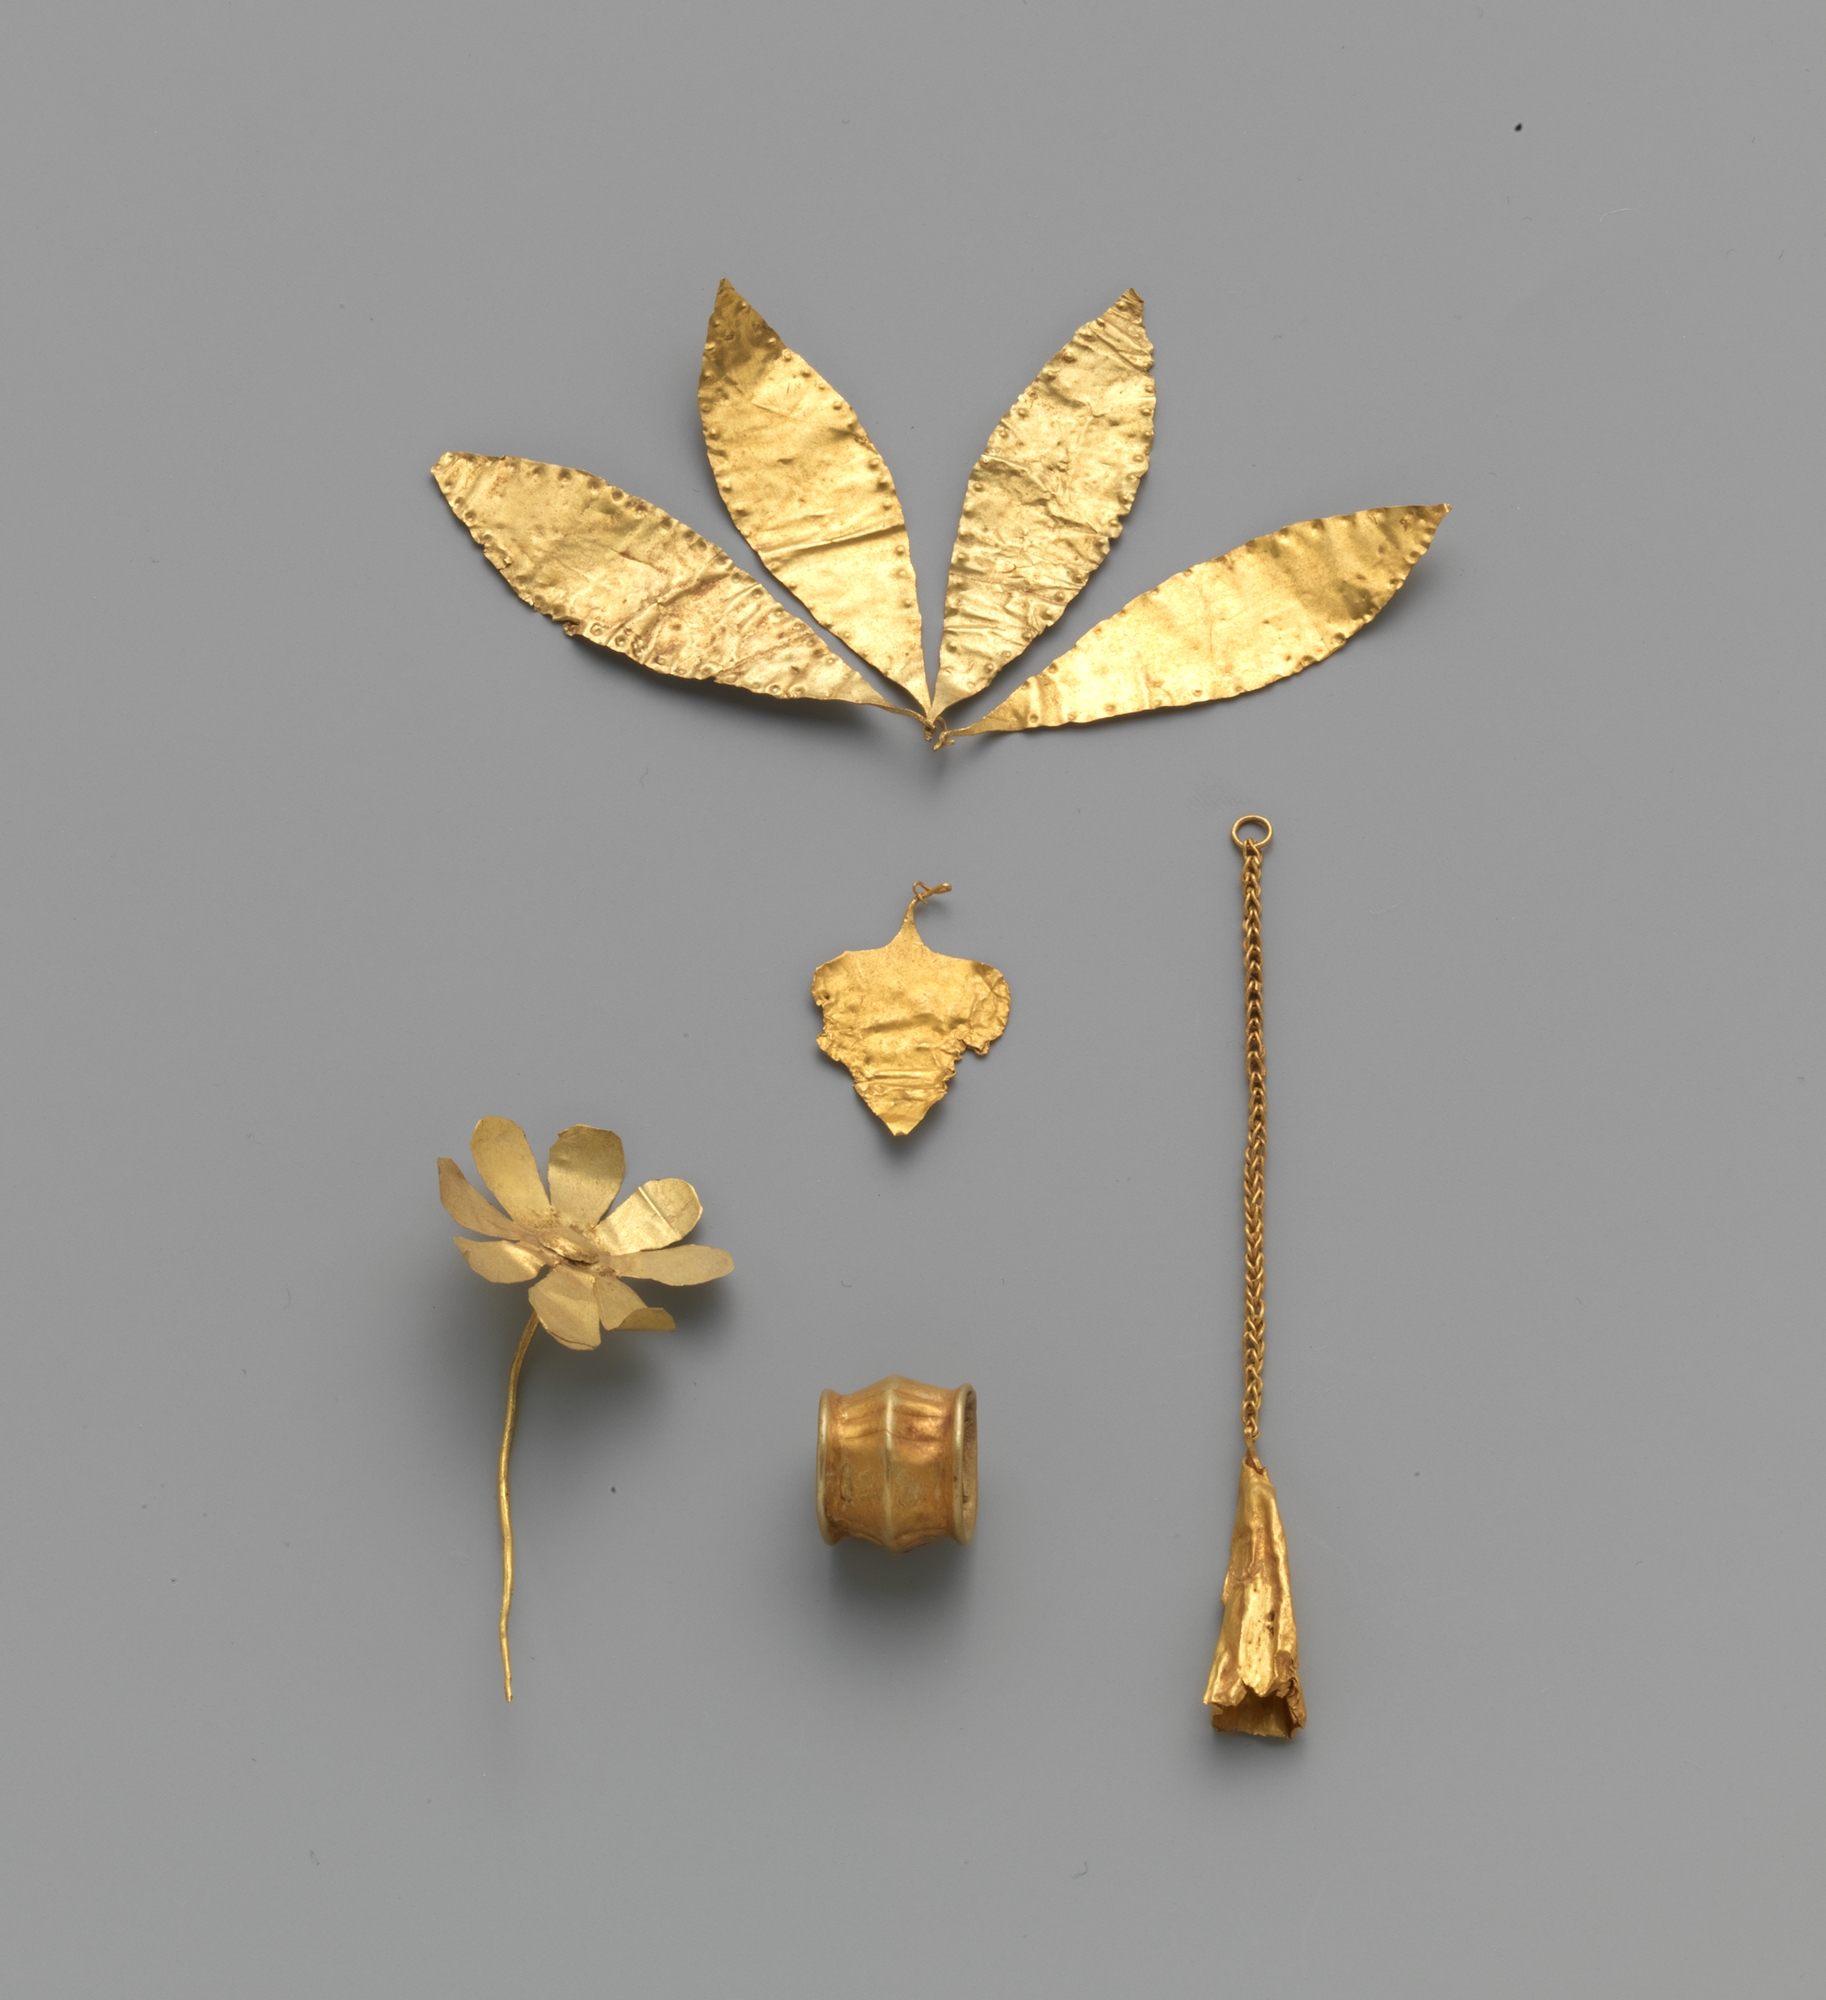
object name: pendant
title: Gold pendant on chain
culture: minoan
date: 2300-2100 BCE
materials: gold